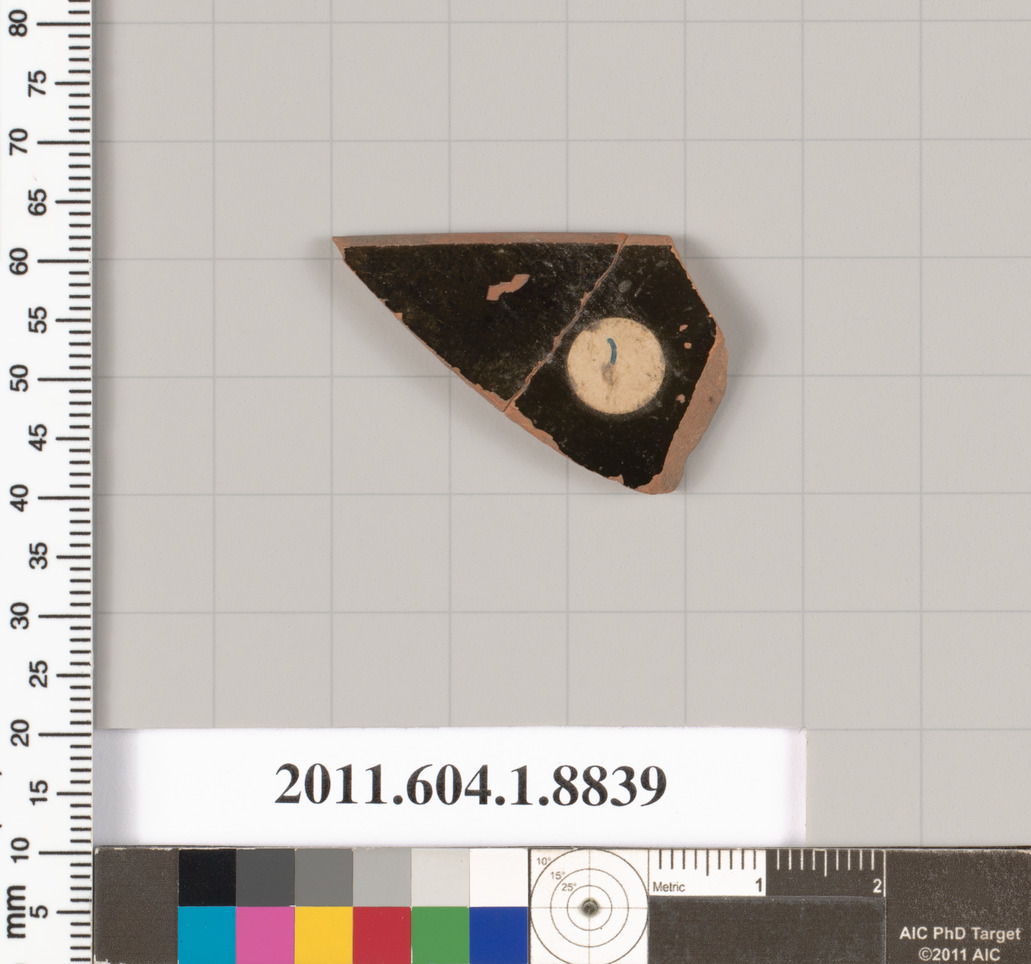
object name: kylix fragment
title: Terracotta rim fragment of a kylix (drinking cup)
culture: greek, attic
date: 490-480 BCE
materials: terracotta